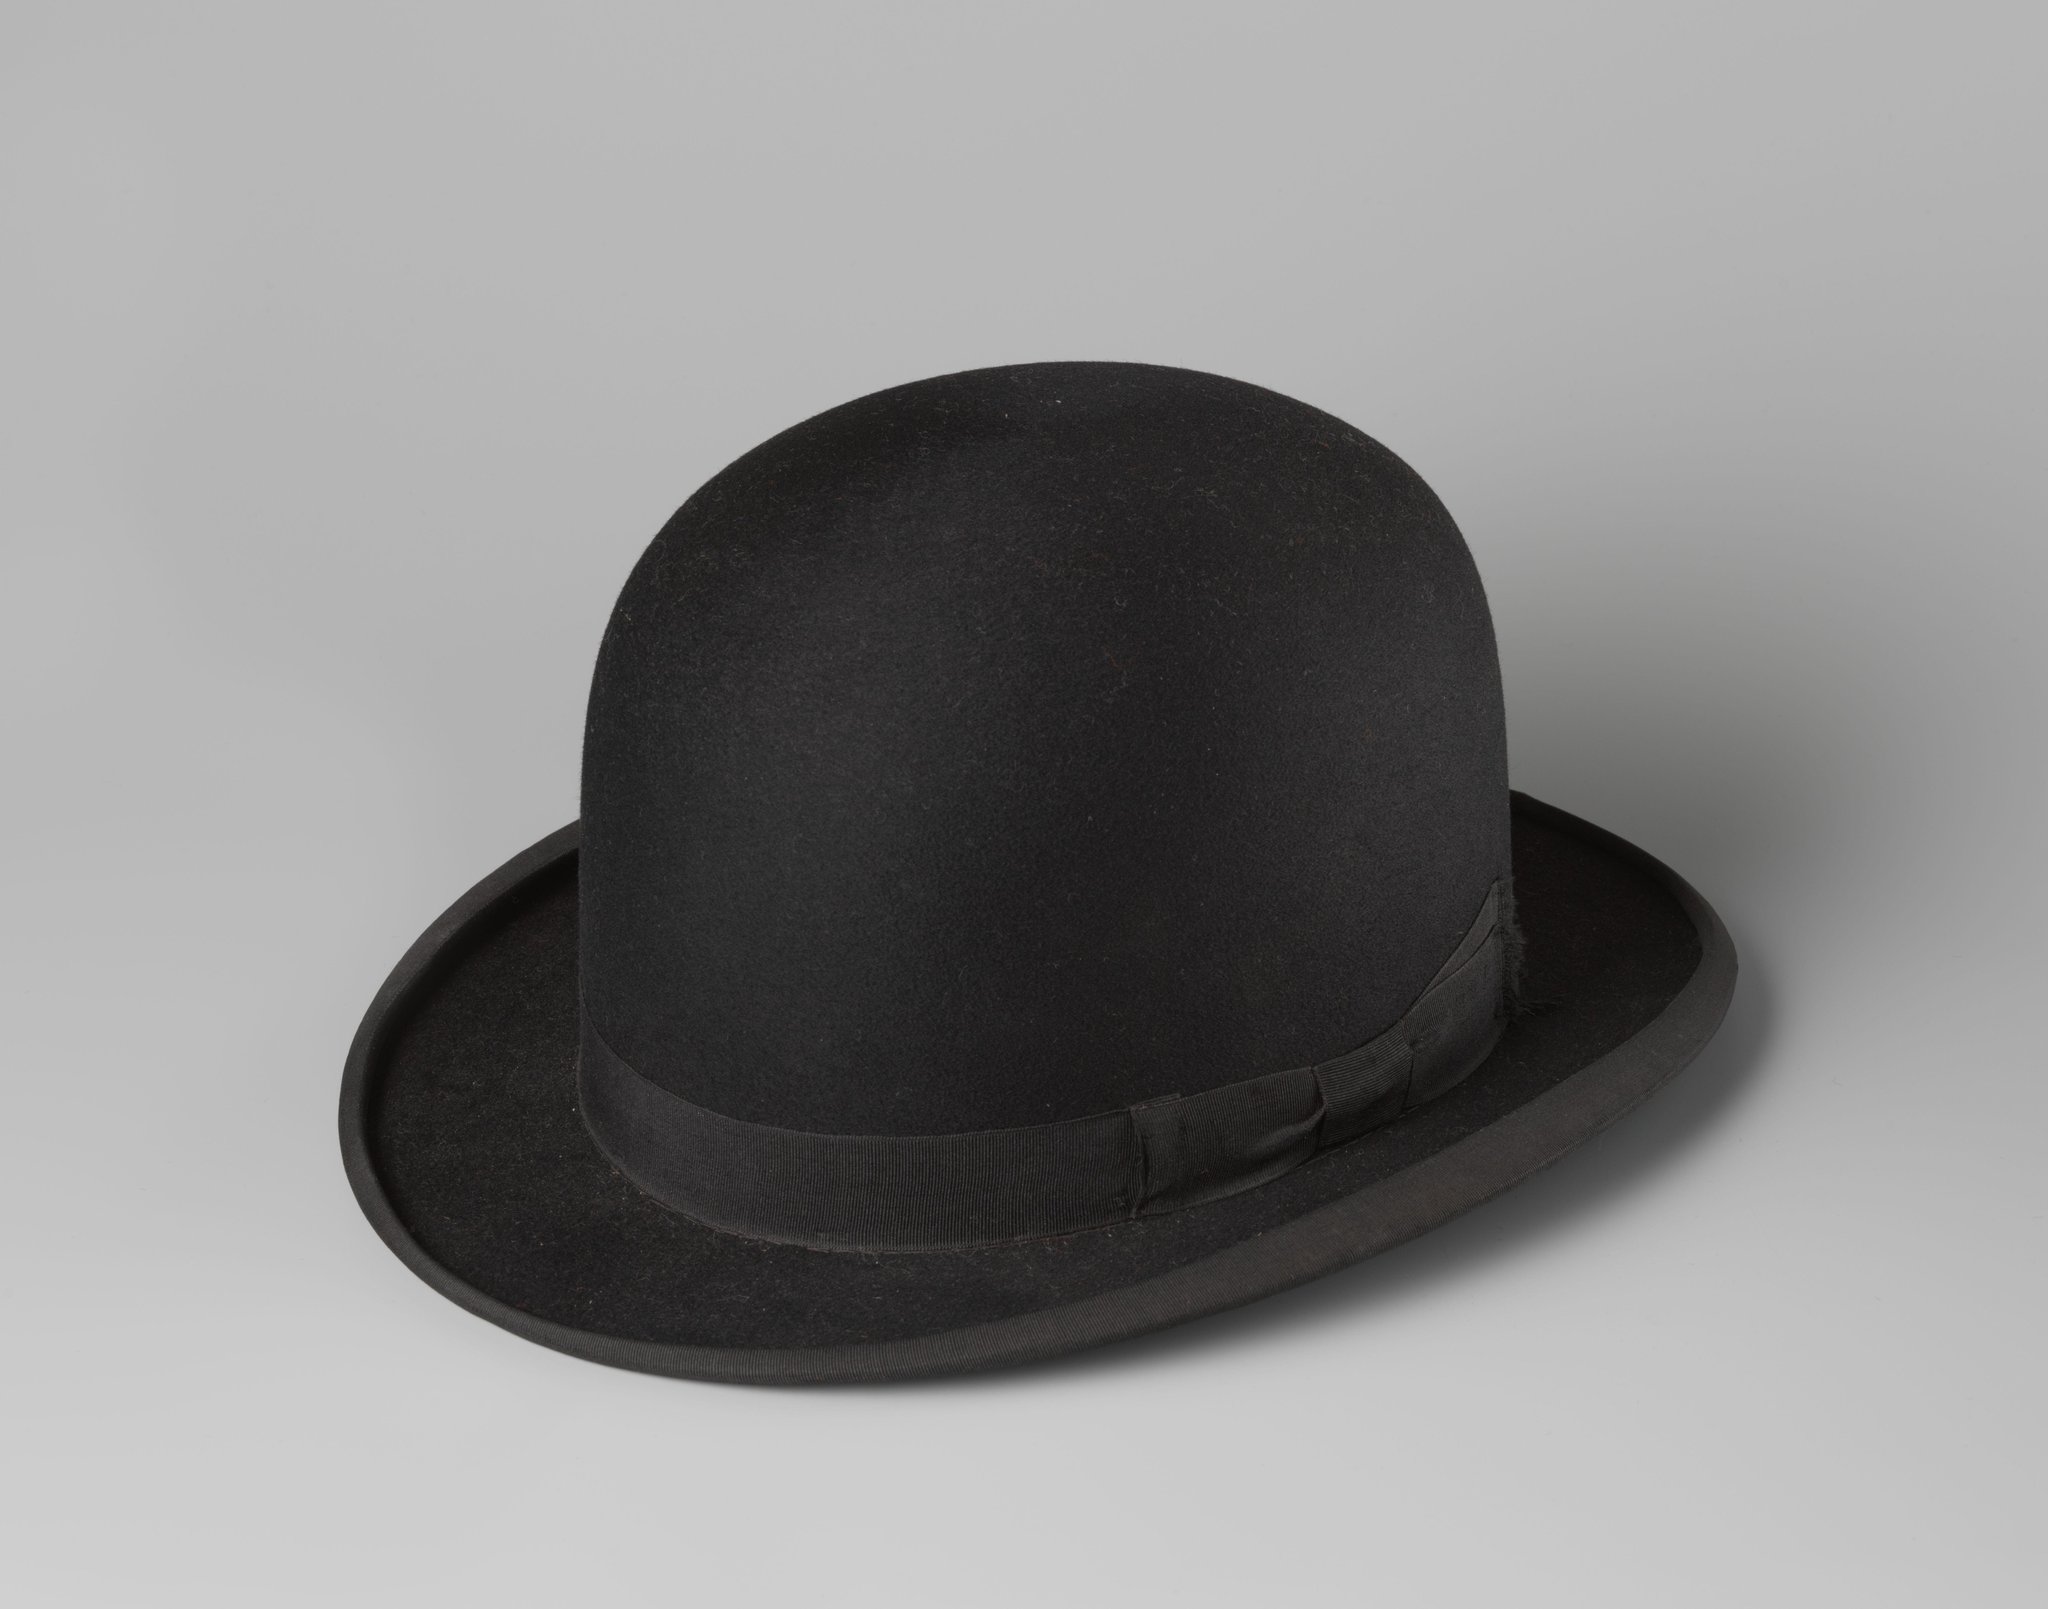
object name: dophoed, bolhoed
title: Bolhoed van zwart laken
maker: Anonymous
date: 1945-1950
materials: textile, leather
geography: england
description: Bolhoed van zwart laken. Rand iets gewelfd en met sterk naar binnengebogen buitenkant waarop een zwart ripslintje is genaaid. Om de bol een zelfde hoedenlint. Voering van wit satijn en bruin leren hoofdband. Wapen in gouddruk van de Prince of Wales (?).